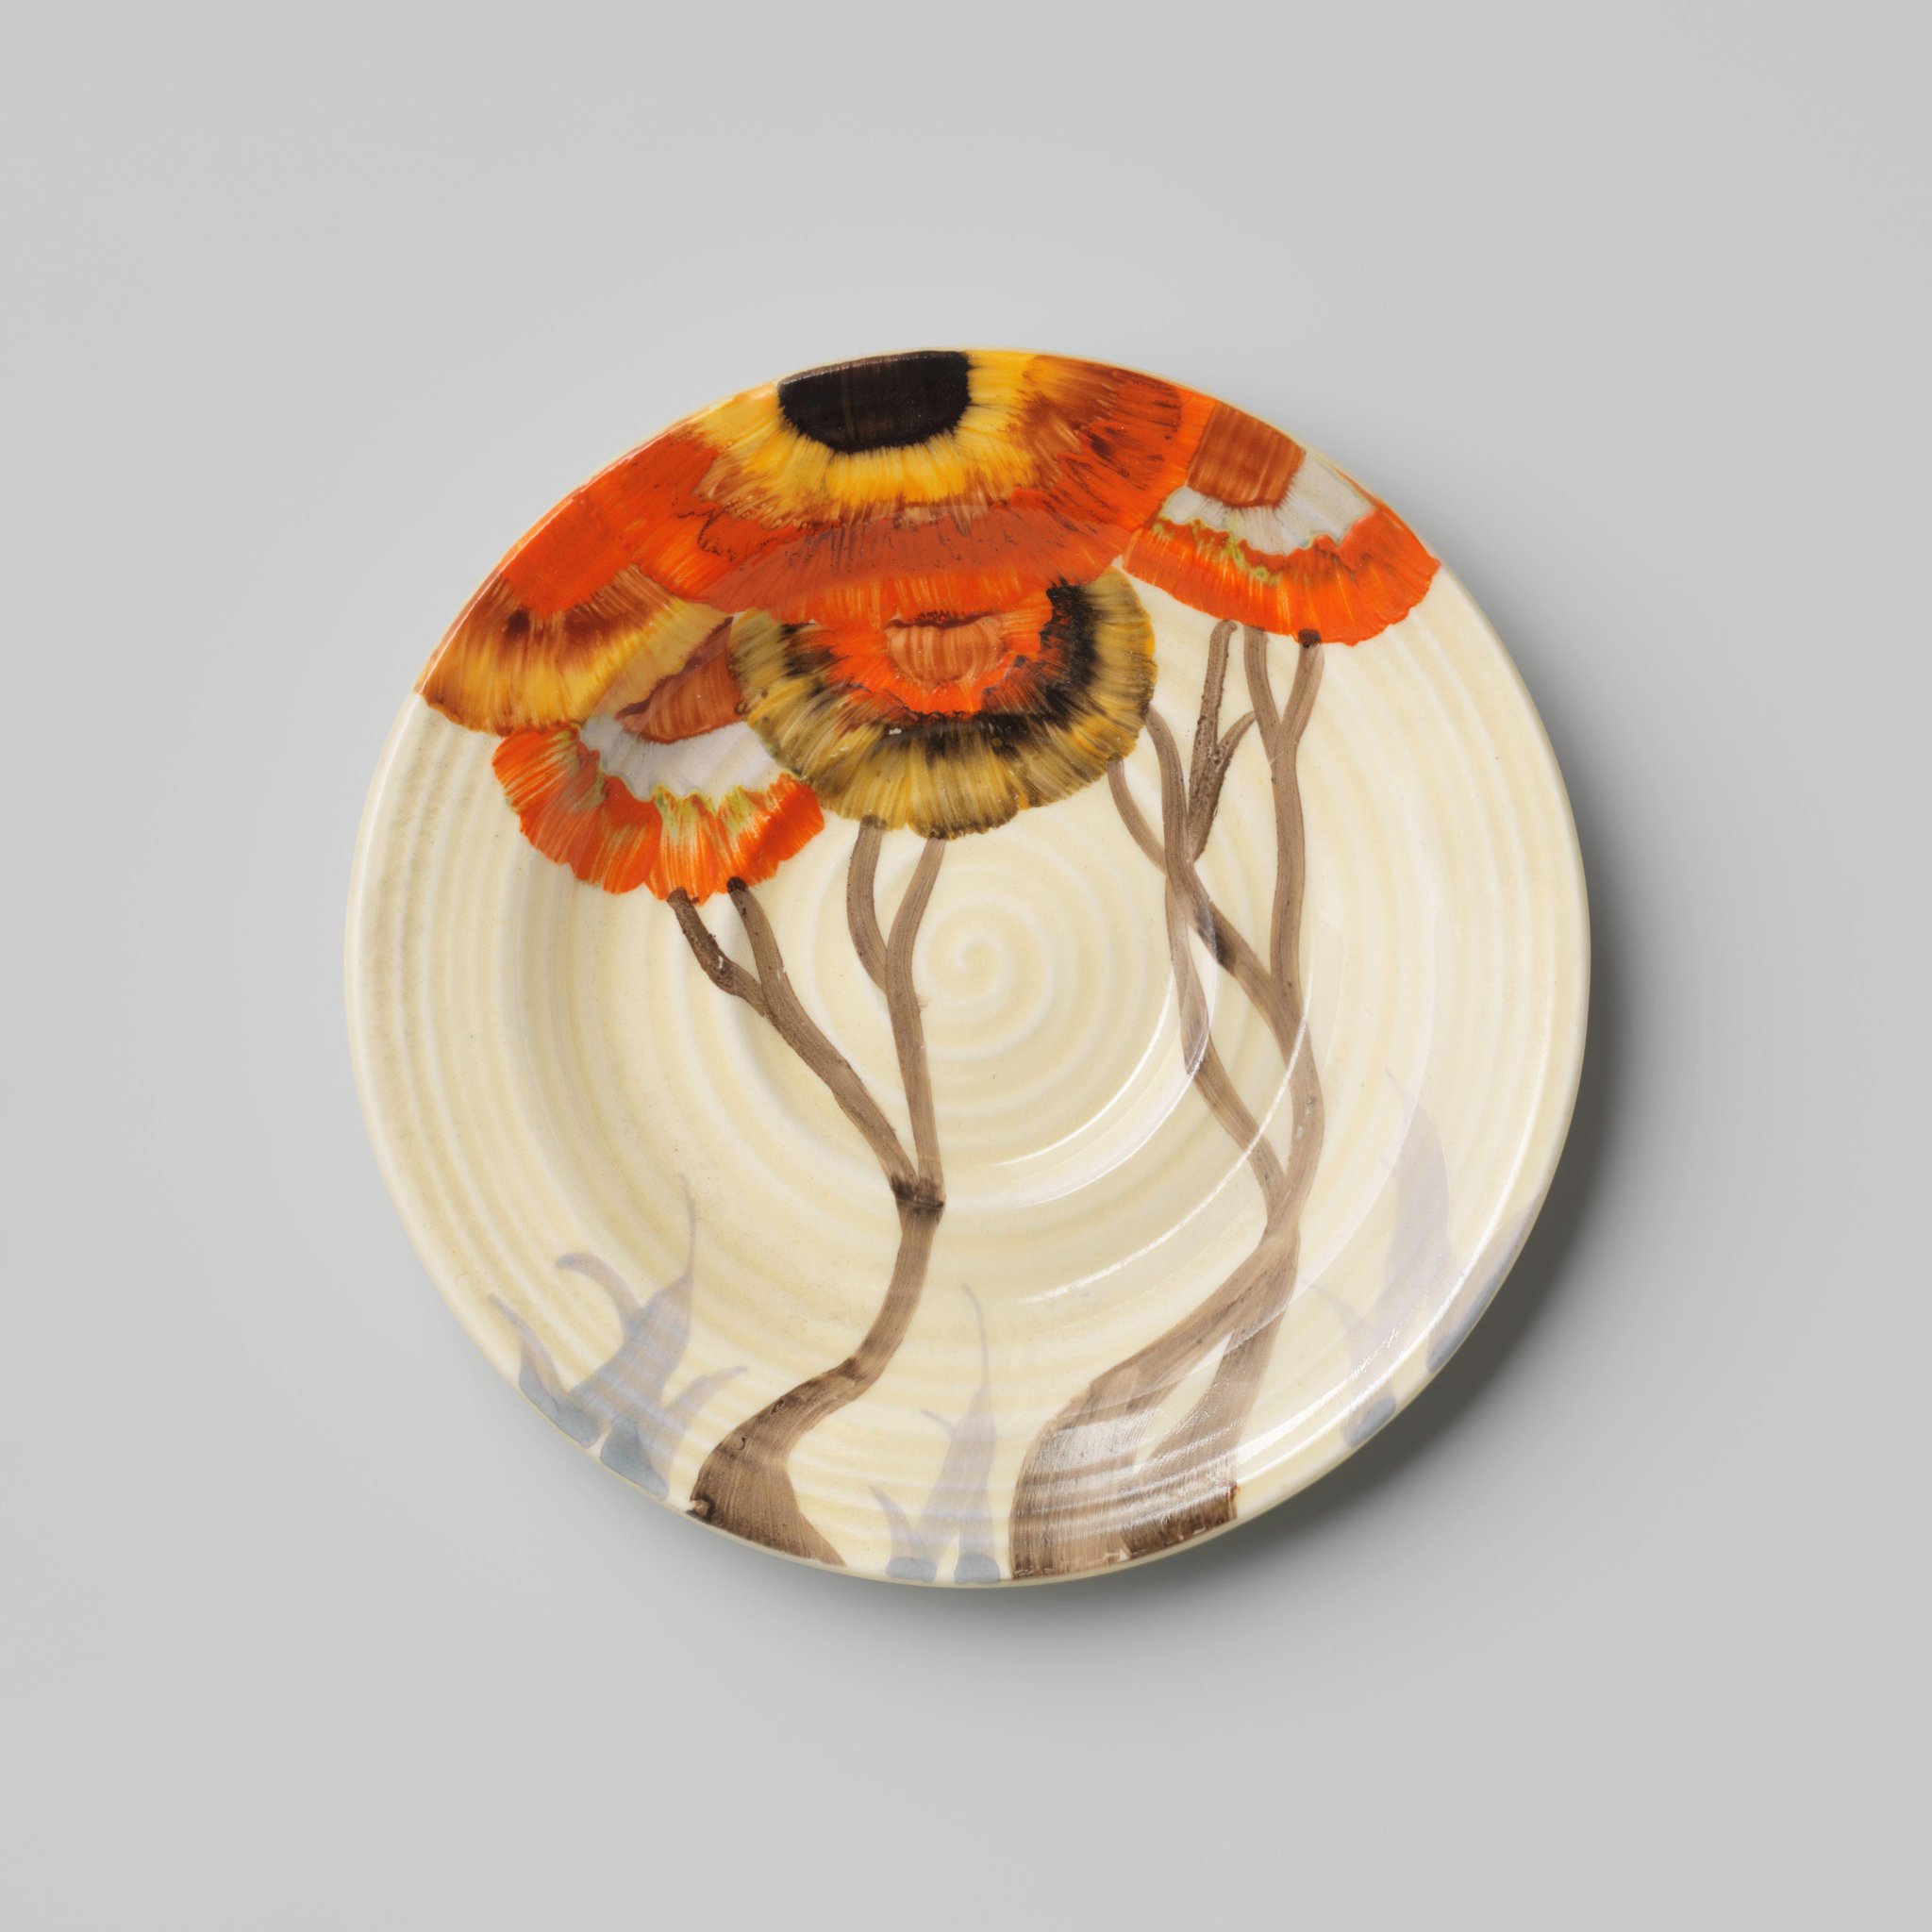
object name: platter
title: Schotel met veelkleurig bloemendecor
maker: clarice cliff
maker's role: ceramicist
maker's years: 1899-1972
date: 1930-1940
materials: earthenware, chemical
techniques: painted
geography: england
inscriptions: mark: ‘HAND PAINTED, BIZARRE by CLARICE CLIFF, WILKINSON Ltd, ENGLAND, gestempeld in zwart’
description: Schotel van aardewerk, veelkleurig beschilderd met bloemendecor. Onderdeel van theeservies.